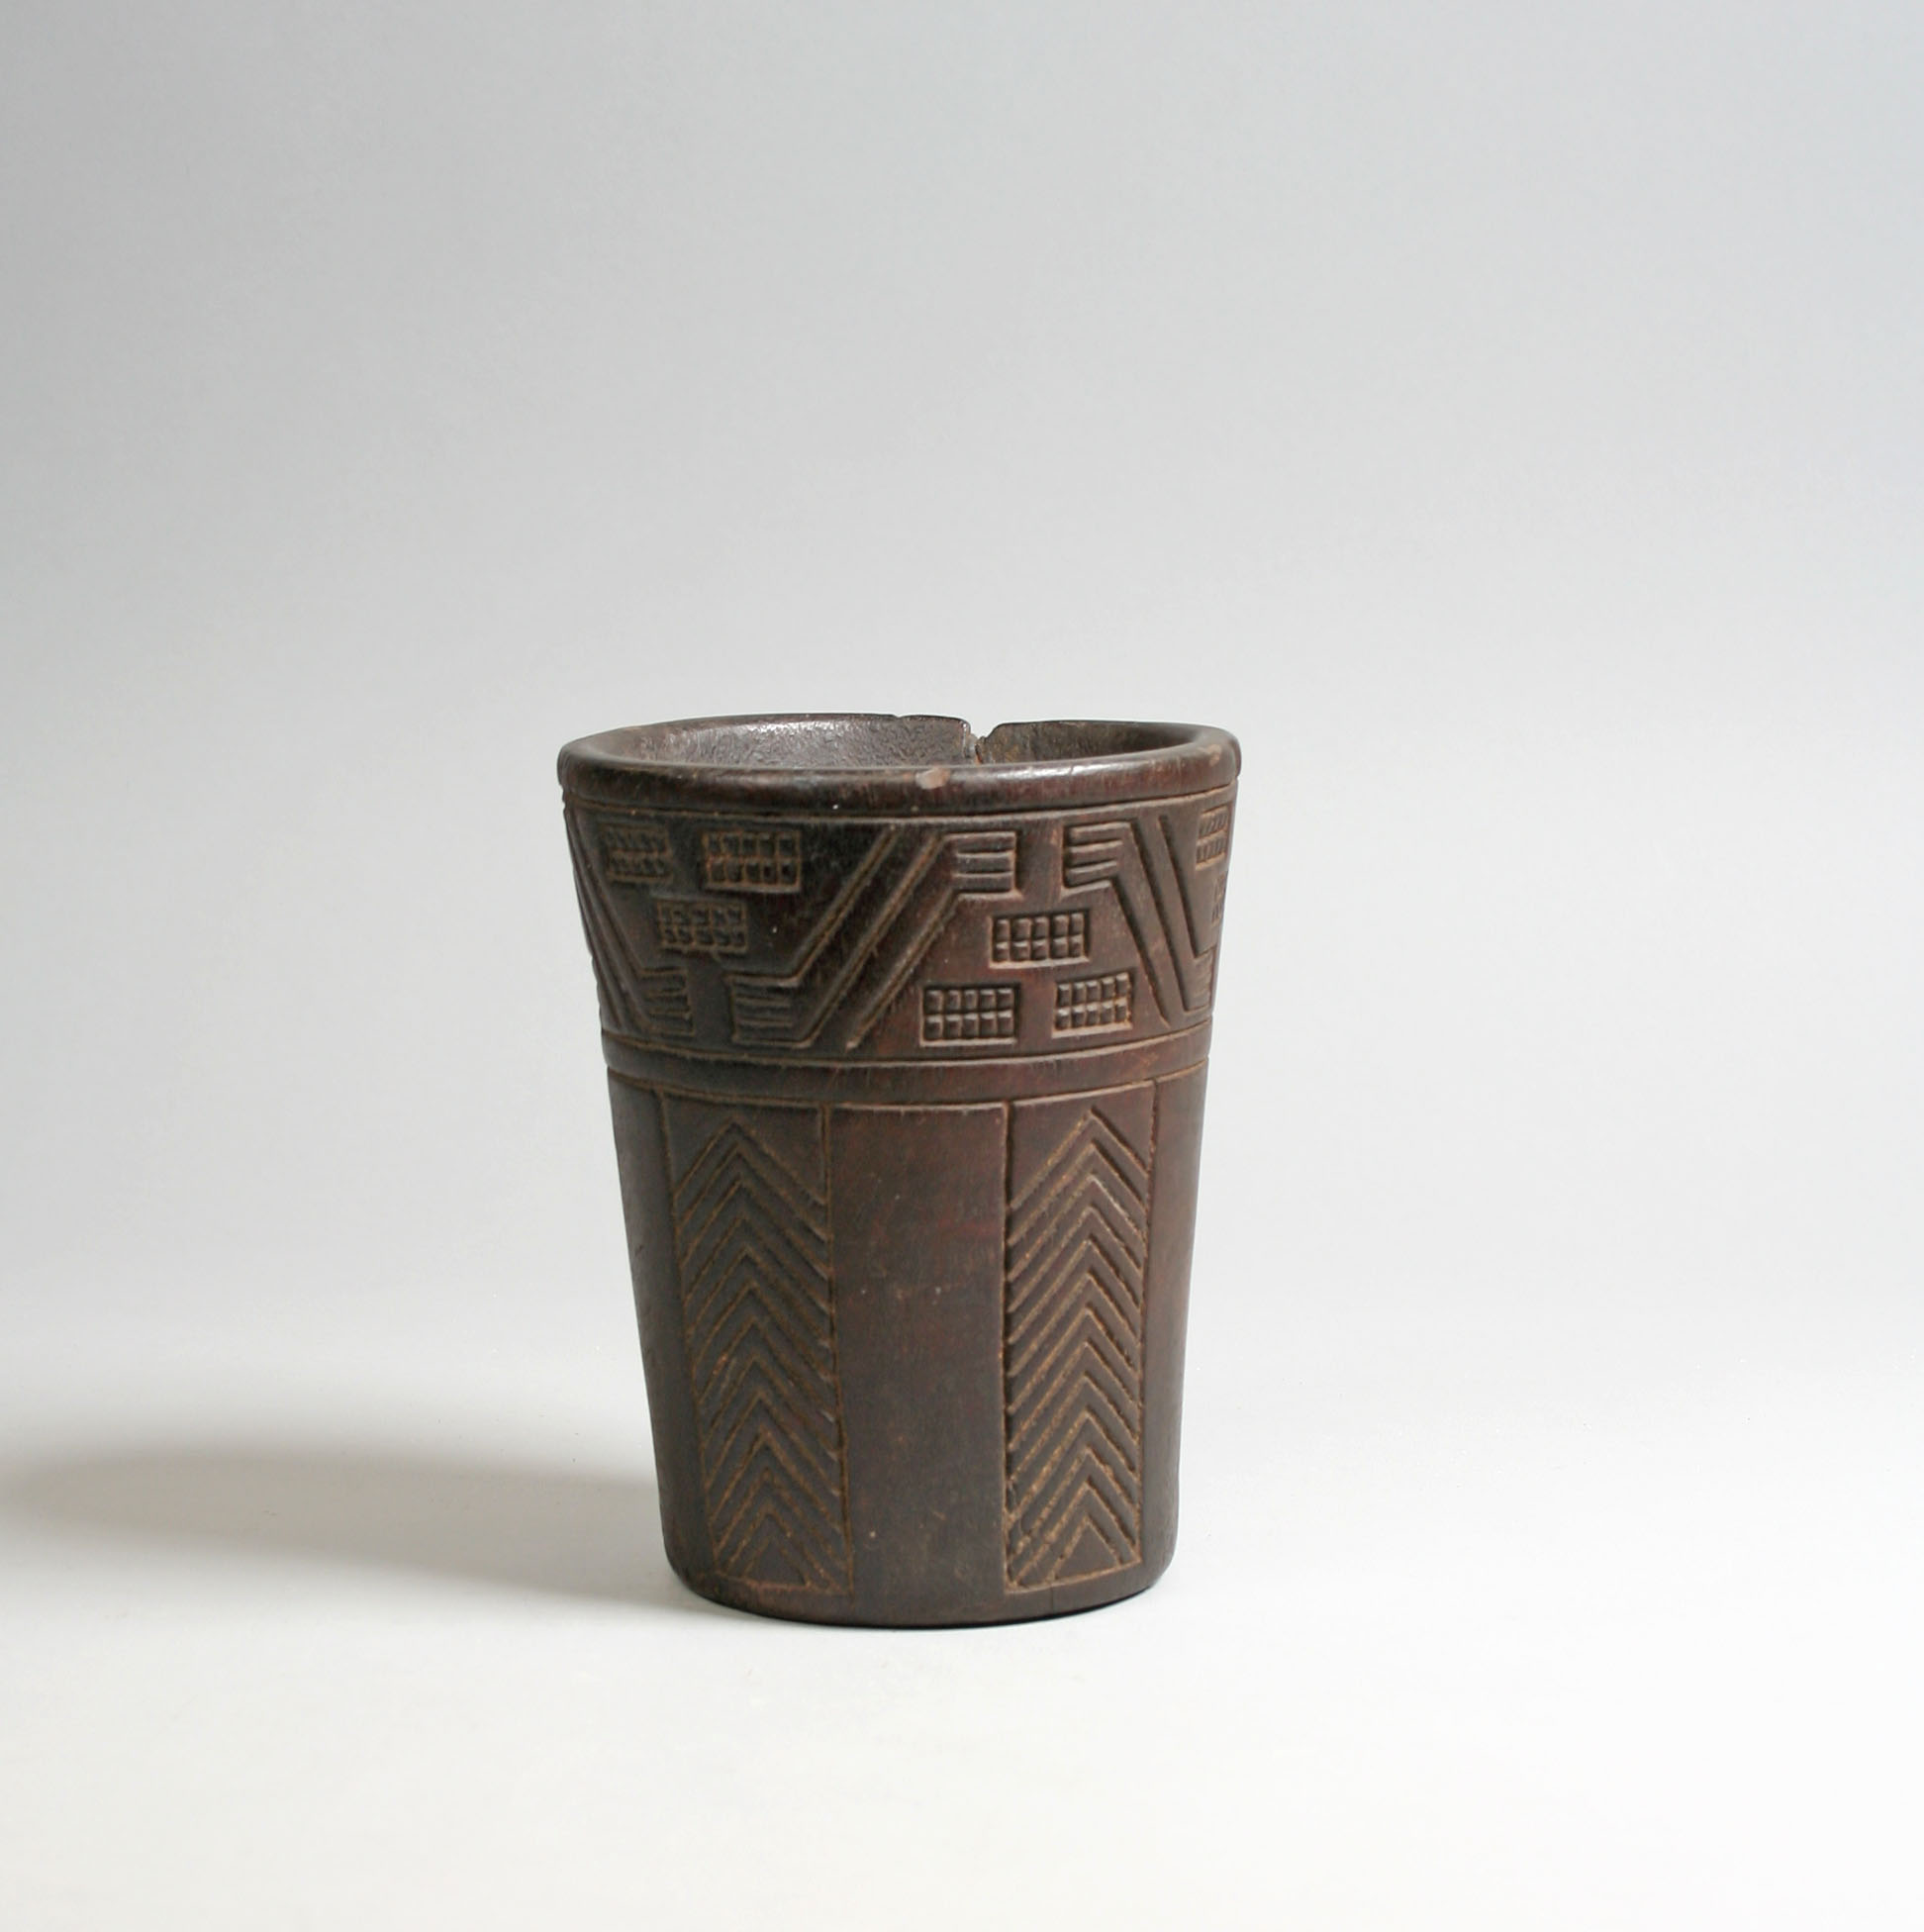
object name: kero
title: Kero (beaker)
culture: inca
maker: inca artist(s)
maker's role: artist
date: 1400-1535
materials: wood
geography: peru